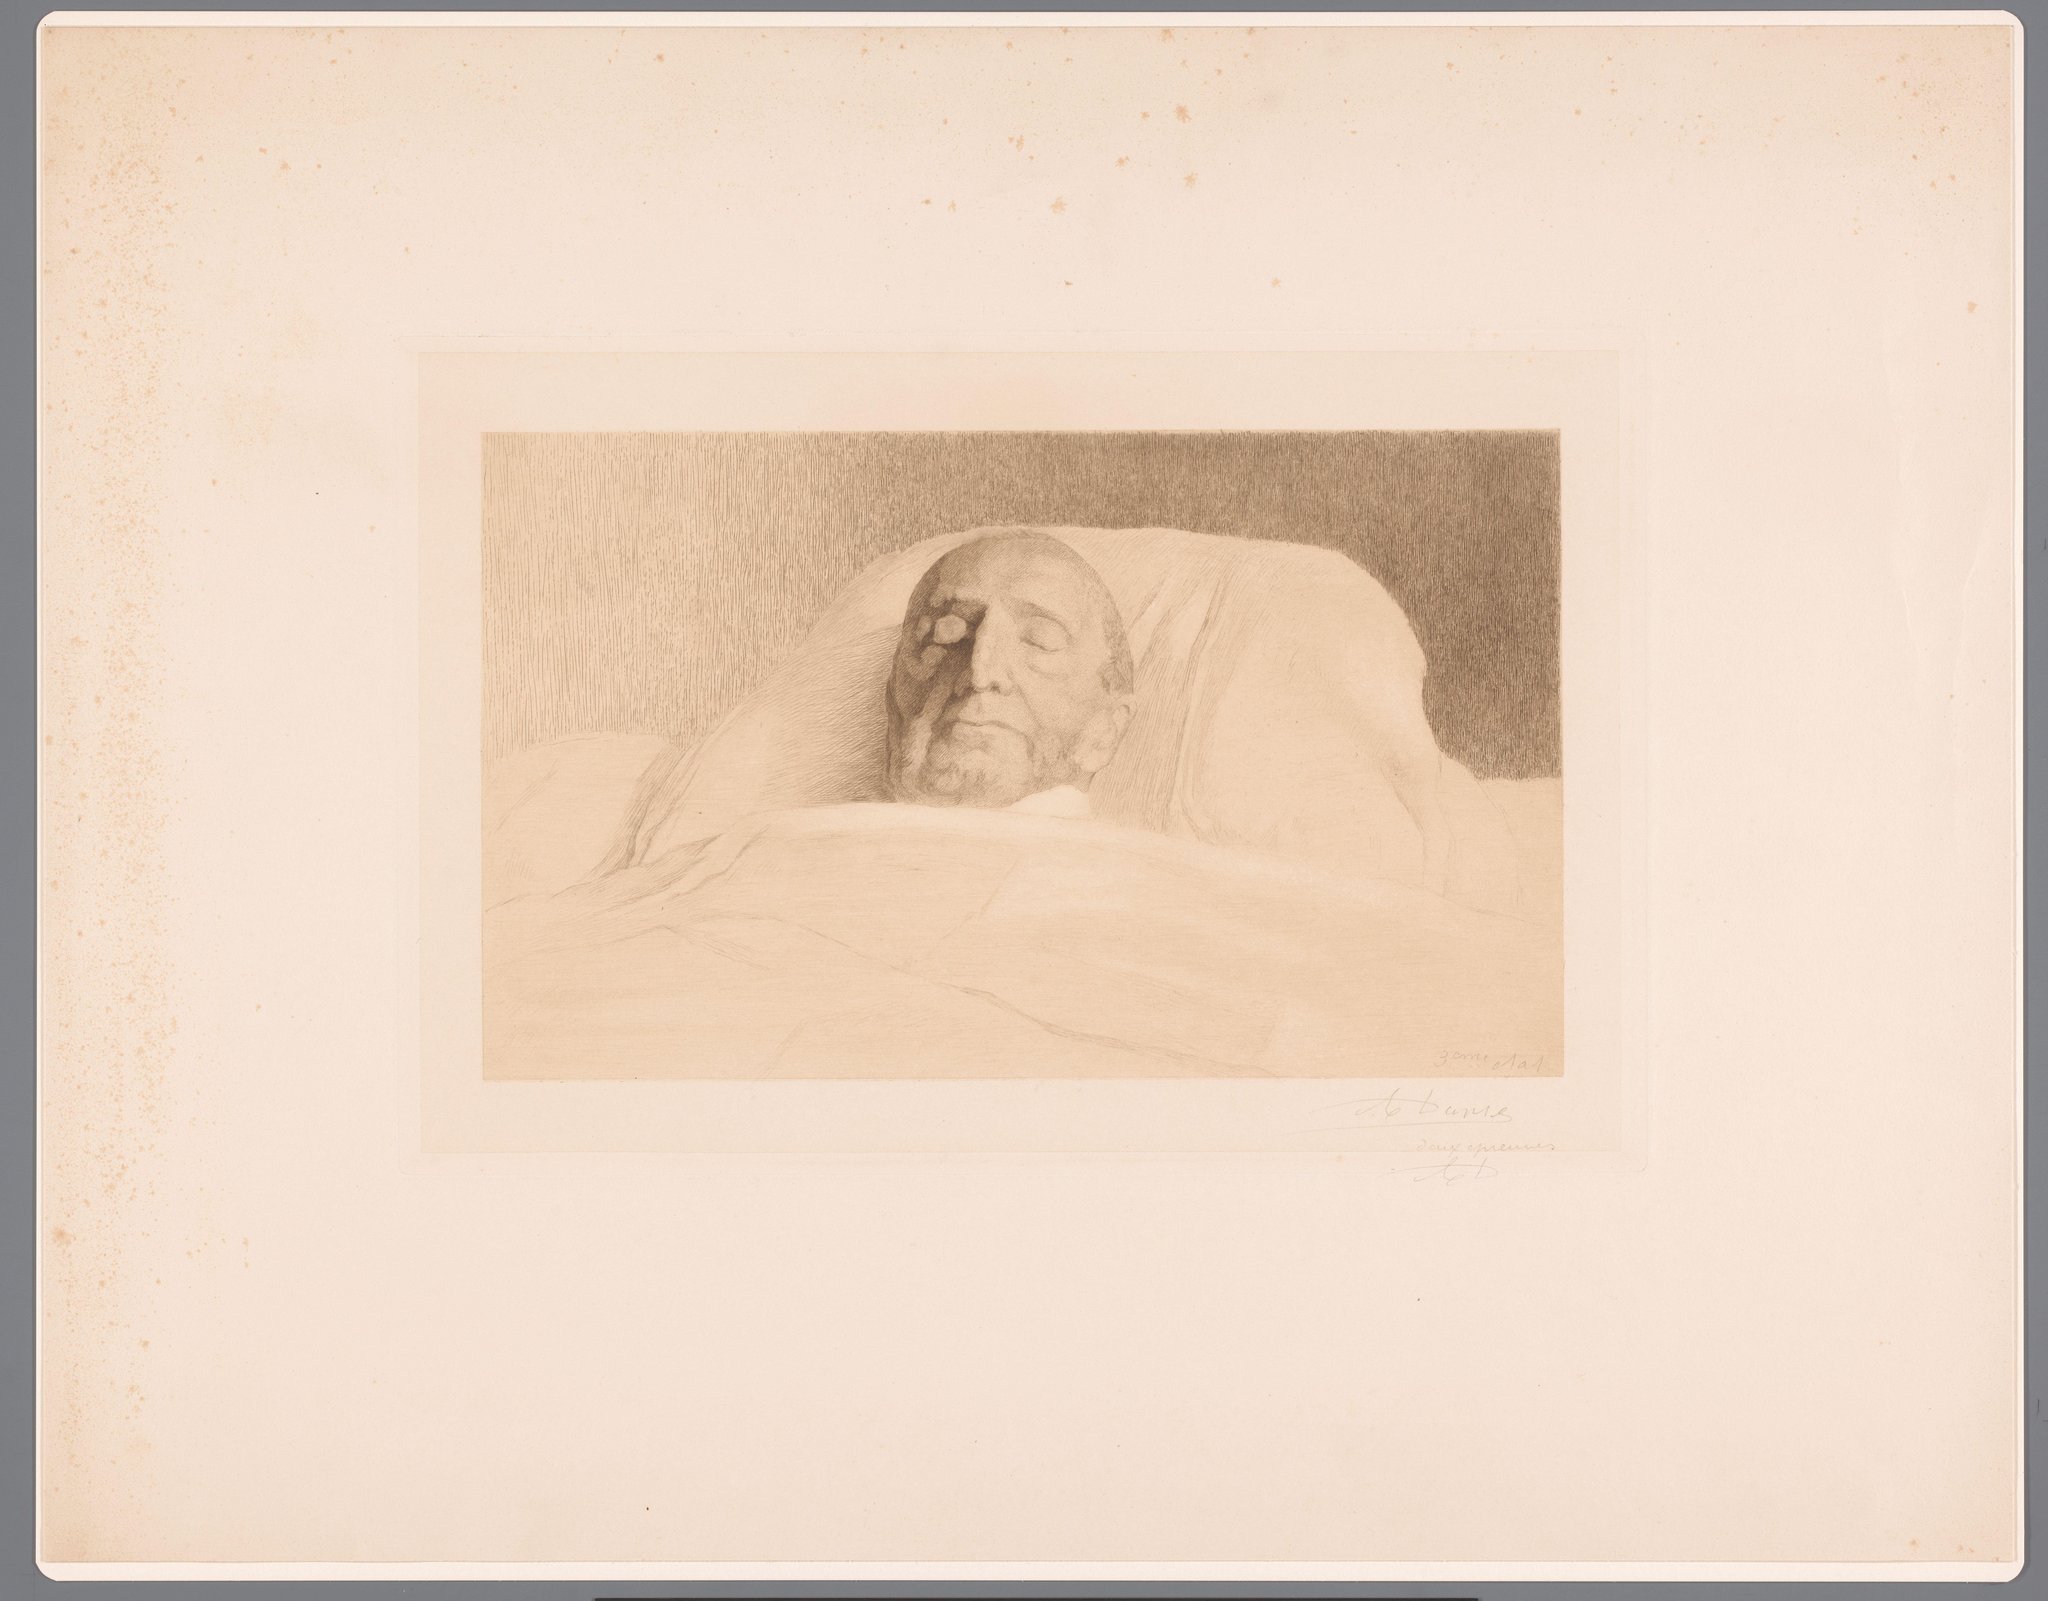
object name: print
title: Portret van een onbekende man op zijn sterfbed, mogelijk Van Volxem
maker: auguste danse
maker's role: print maker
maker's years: 1829-1929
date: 1897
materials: paper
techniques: etching, intaglio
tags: death in old age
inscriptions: annotation: ‘3eme etat; deux epreuves’, collector's mark: Lugt 2228